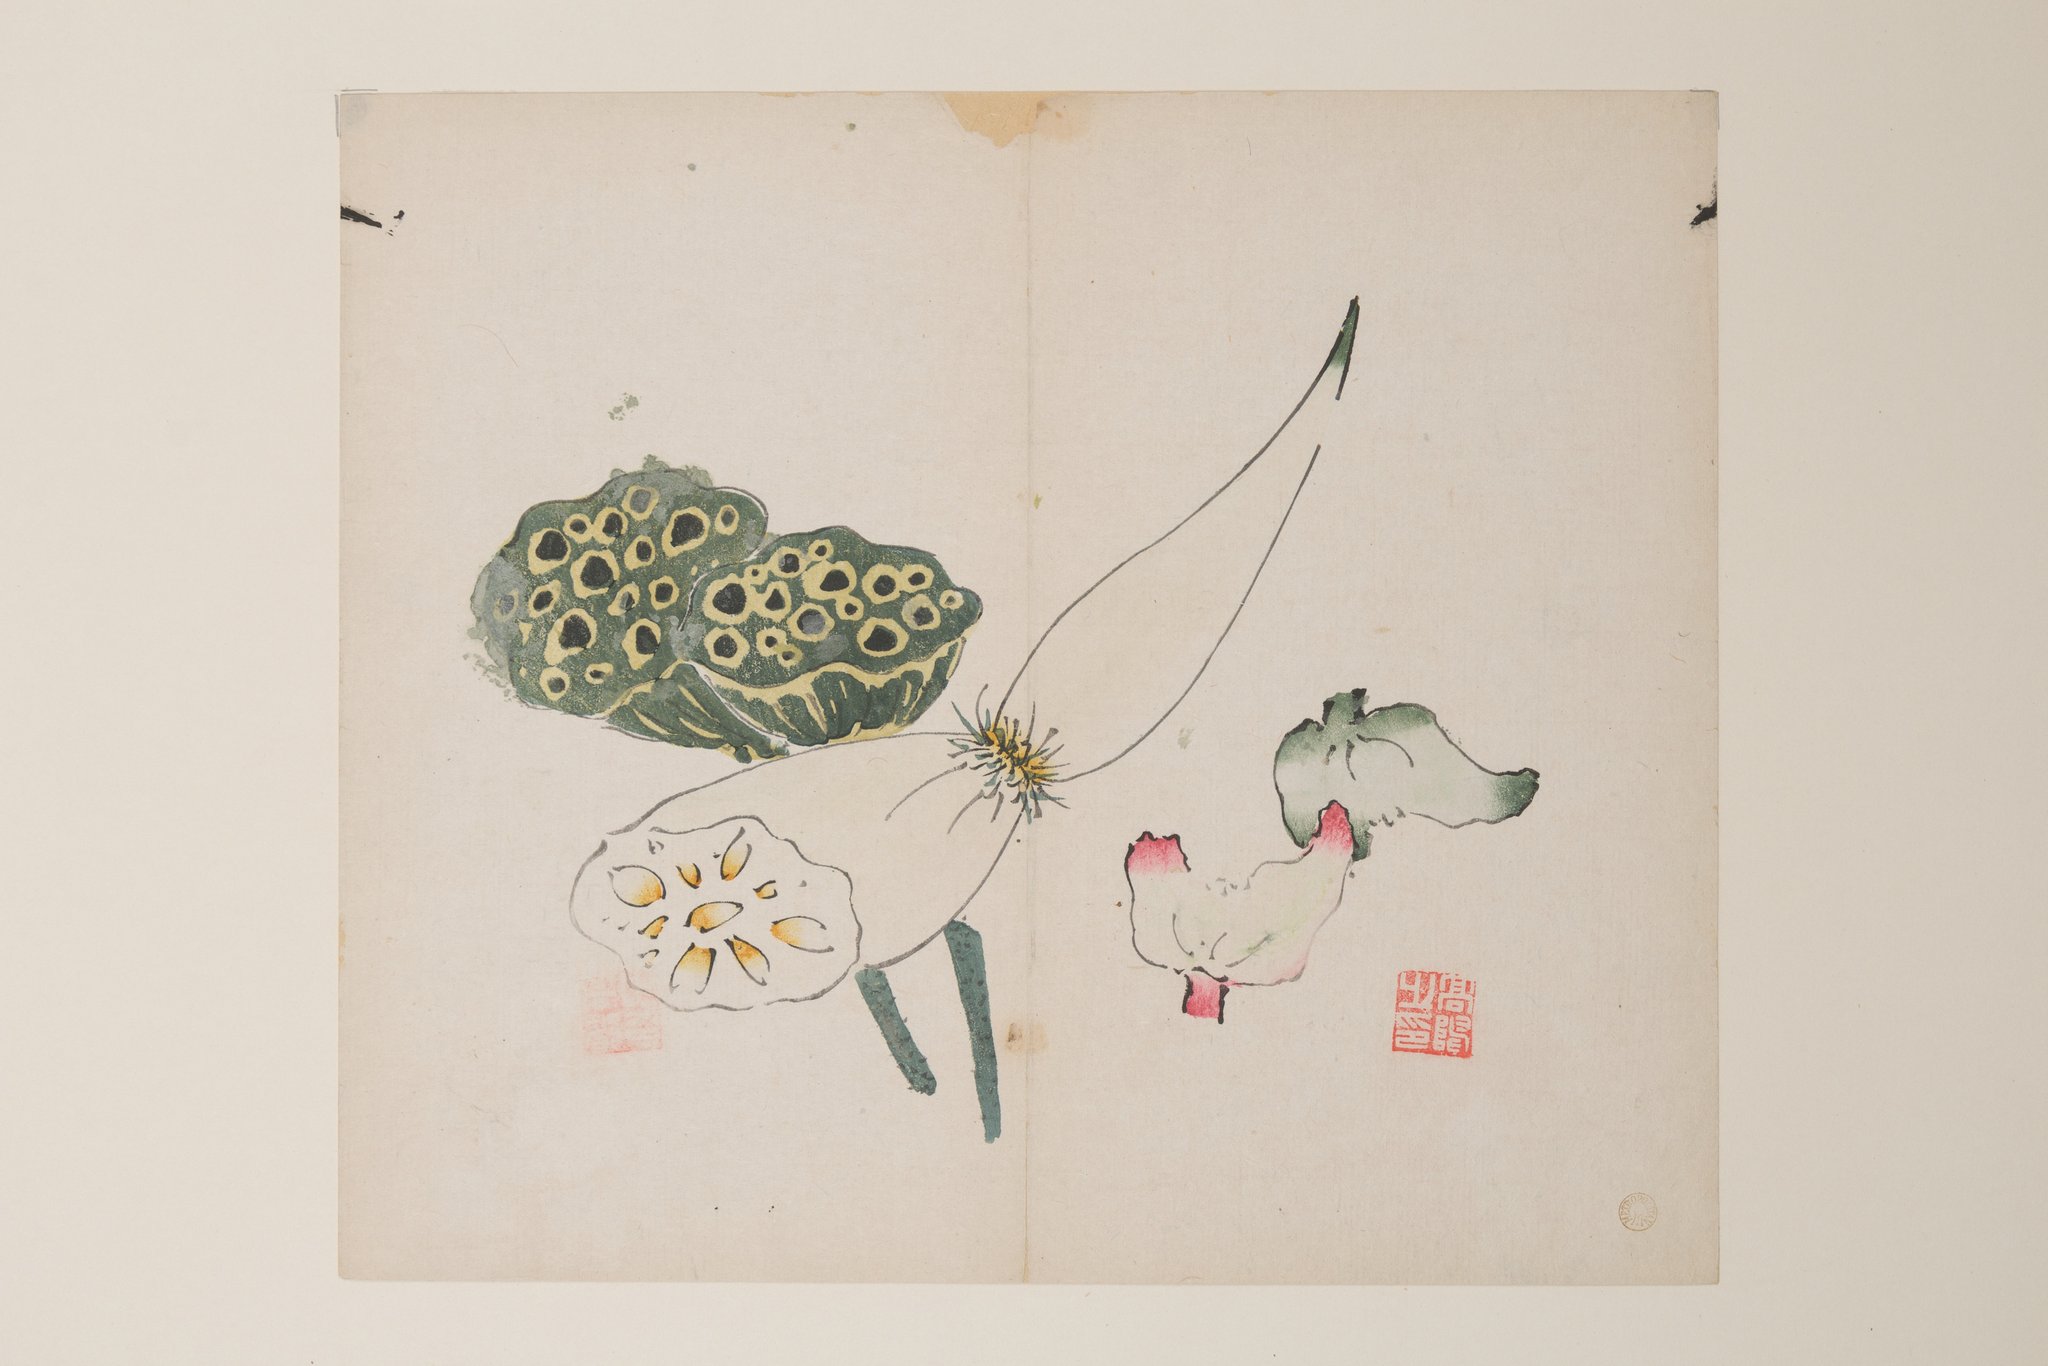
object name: print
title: Page from Shi Zhu Zhai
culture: chinese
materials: ink, paper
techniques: polychrome, woodblock print